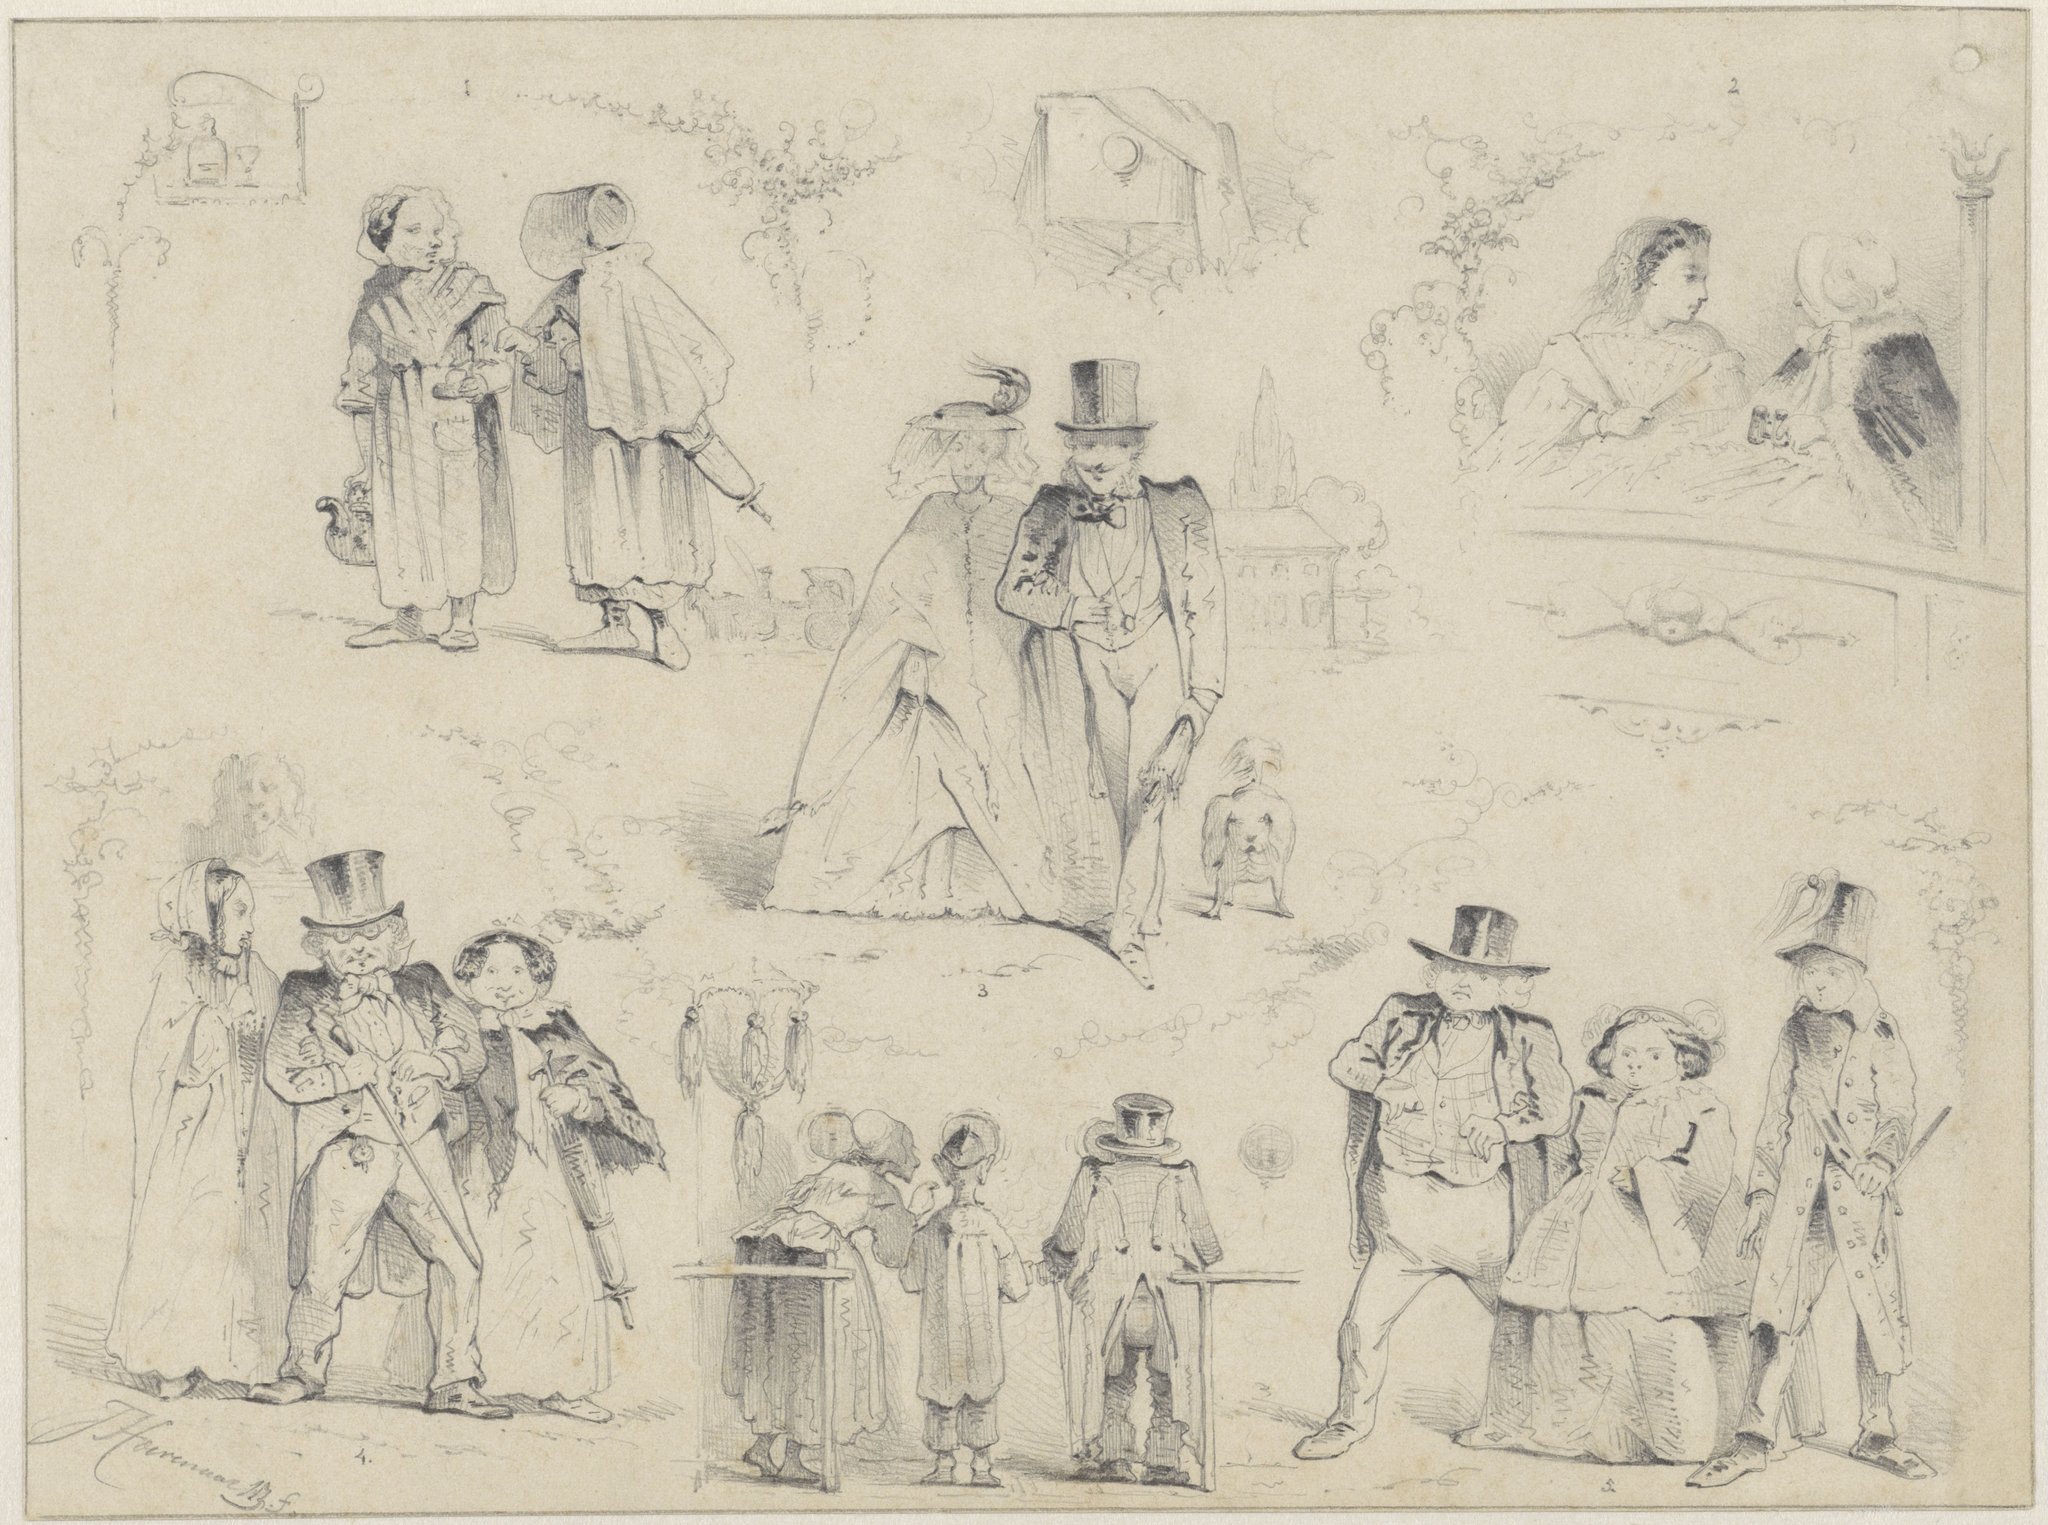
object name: design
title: Diverse typen naar het leven geobserveerd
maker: jozef hoevenaar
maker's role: draughtsman, print maker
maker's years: 1840-1926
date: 1861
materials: paper, pencil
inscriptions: signature: ‘'J.Hoevenaar Wz. f’, date: ‘1861’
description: Ontwerp voor een karikatuur (prent) met vijf kleine tafereeltjes.